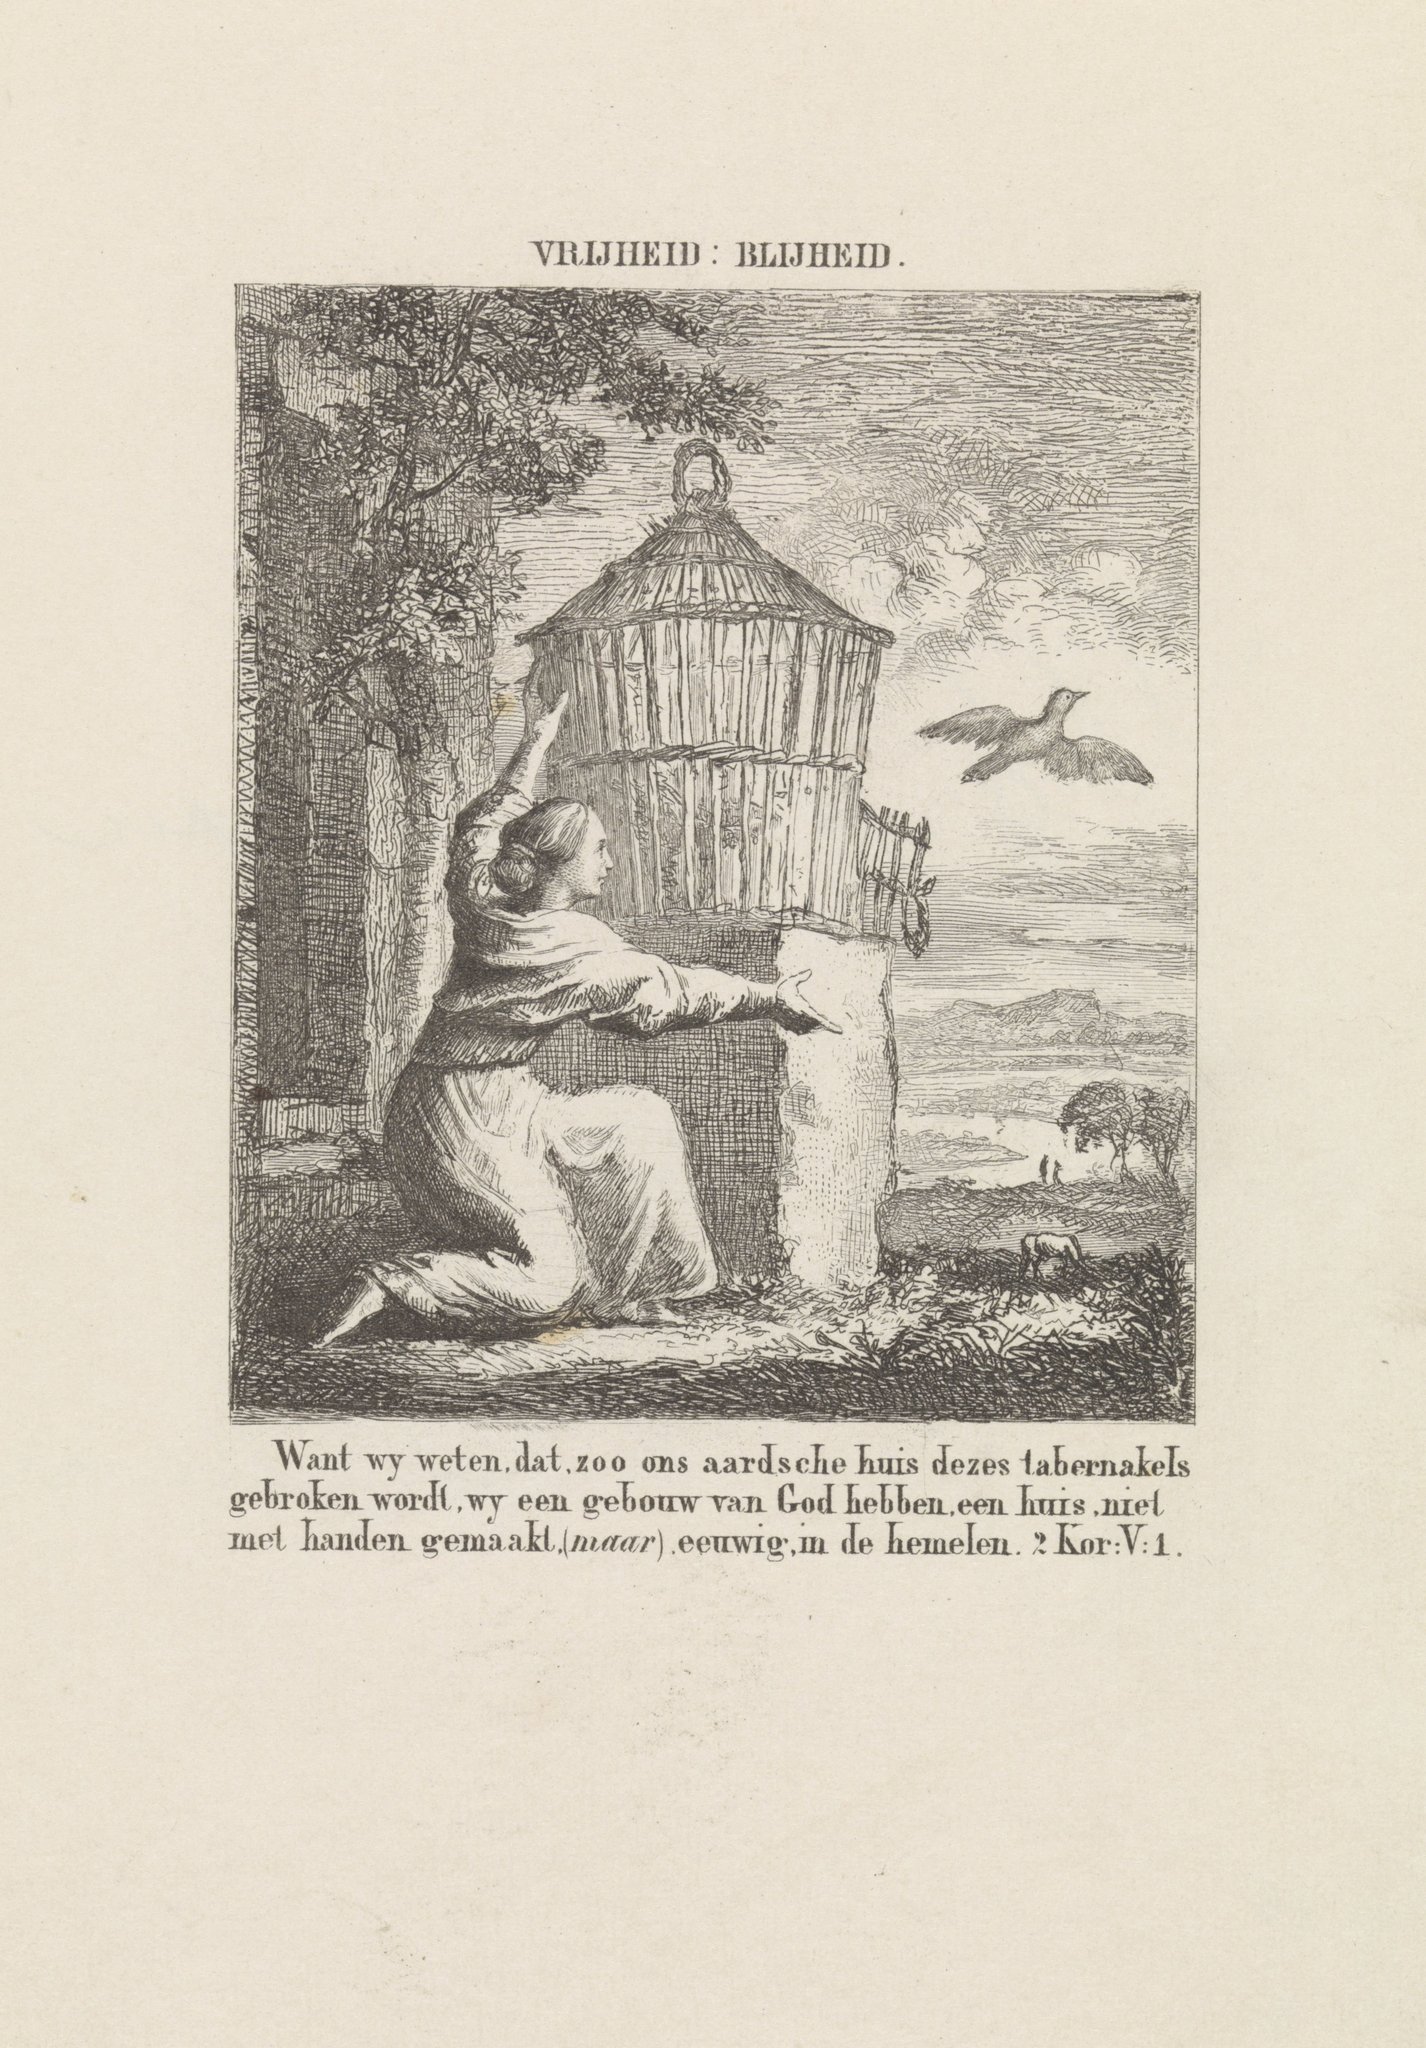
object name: print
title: Vrouw bevrijdt vogel uit kooi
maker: geertruida margaretha jacoba huidekoper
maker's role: print maker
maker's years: 1824-1884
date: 1839-1884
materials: paper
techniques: etching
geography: amsterdam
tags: bird in a cage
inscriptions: collector's mark: Lugt 2228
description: Kopie naar prent in een editie van: Luiken, Jan. De zedelyke en stichtelyke gezangen. Amsterdam: Willem de Coup, 1698.